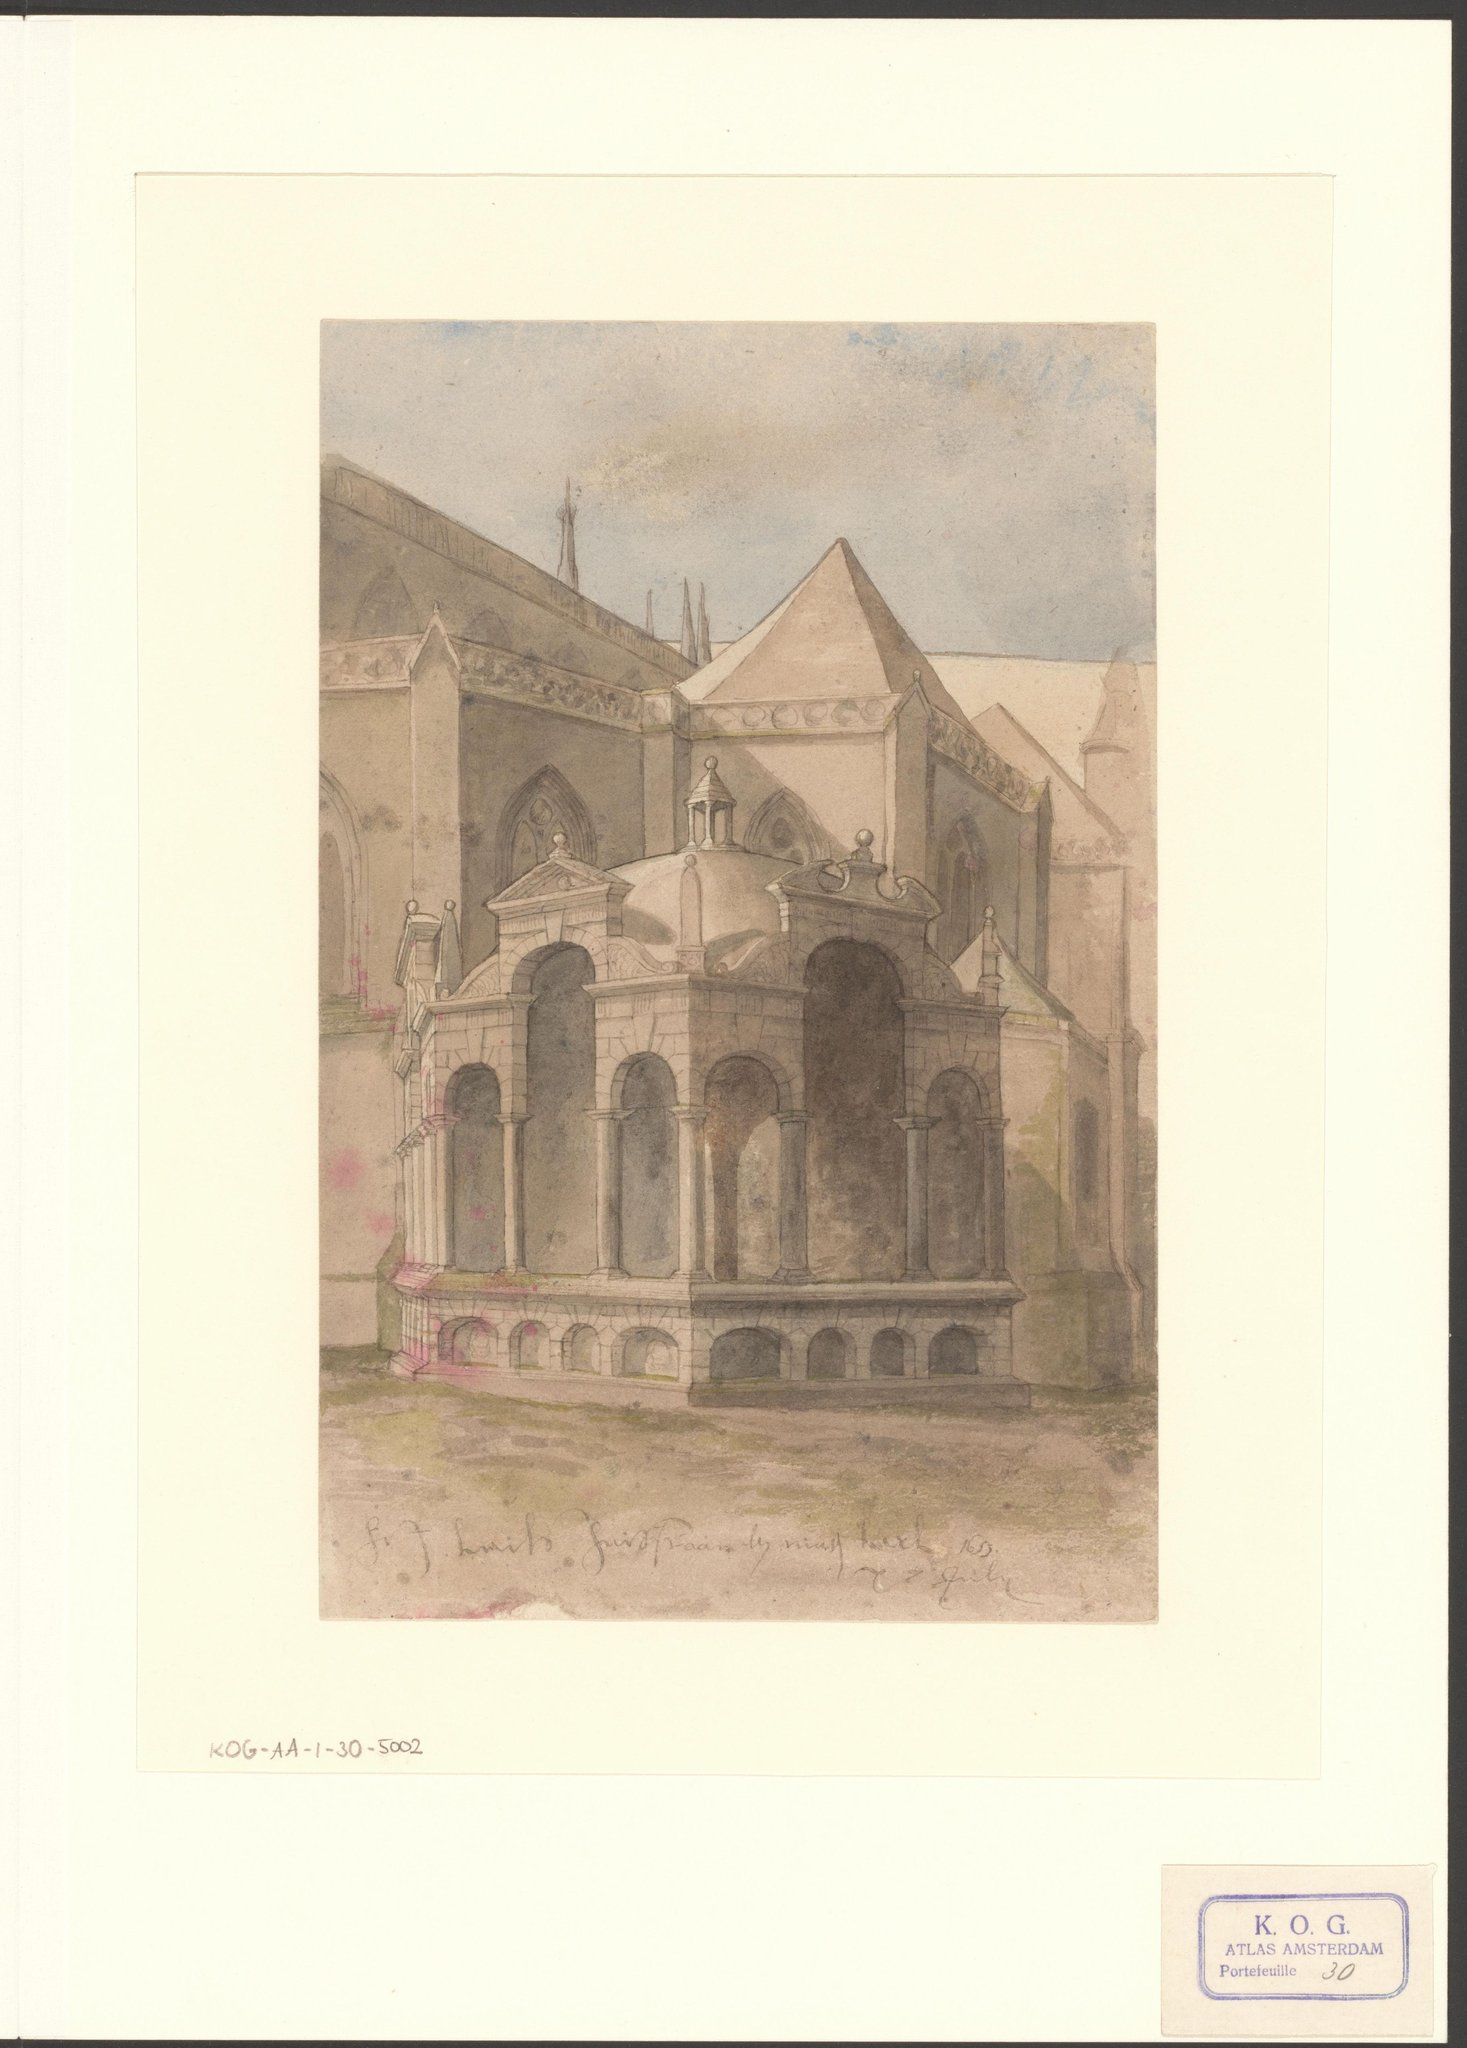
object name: drawing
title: Gezicht op het Bekkeneelshuisje van de Nieuwe Kerk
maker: Anonymous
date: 1653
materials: ink, paper, pencil, watercolor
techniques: brush, pen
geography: amsterdam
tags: city-view in general; 'veduta', church (exterior)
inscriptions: collector's mark: ‘30’ Lugt 1641b, inscription: ‘[...] huis suid[...]aan by niey kerk 1653 / [...]ly’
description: Onderwerpsrubriek binnen de Atlas Amsterdam: Nieuwe Kerk van buiten.